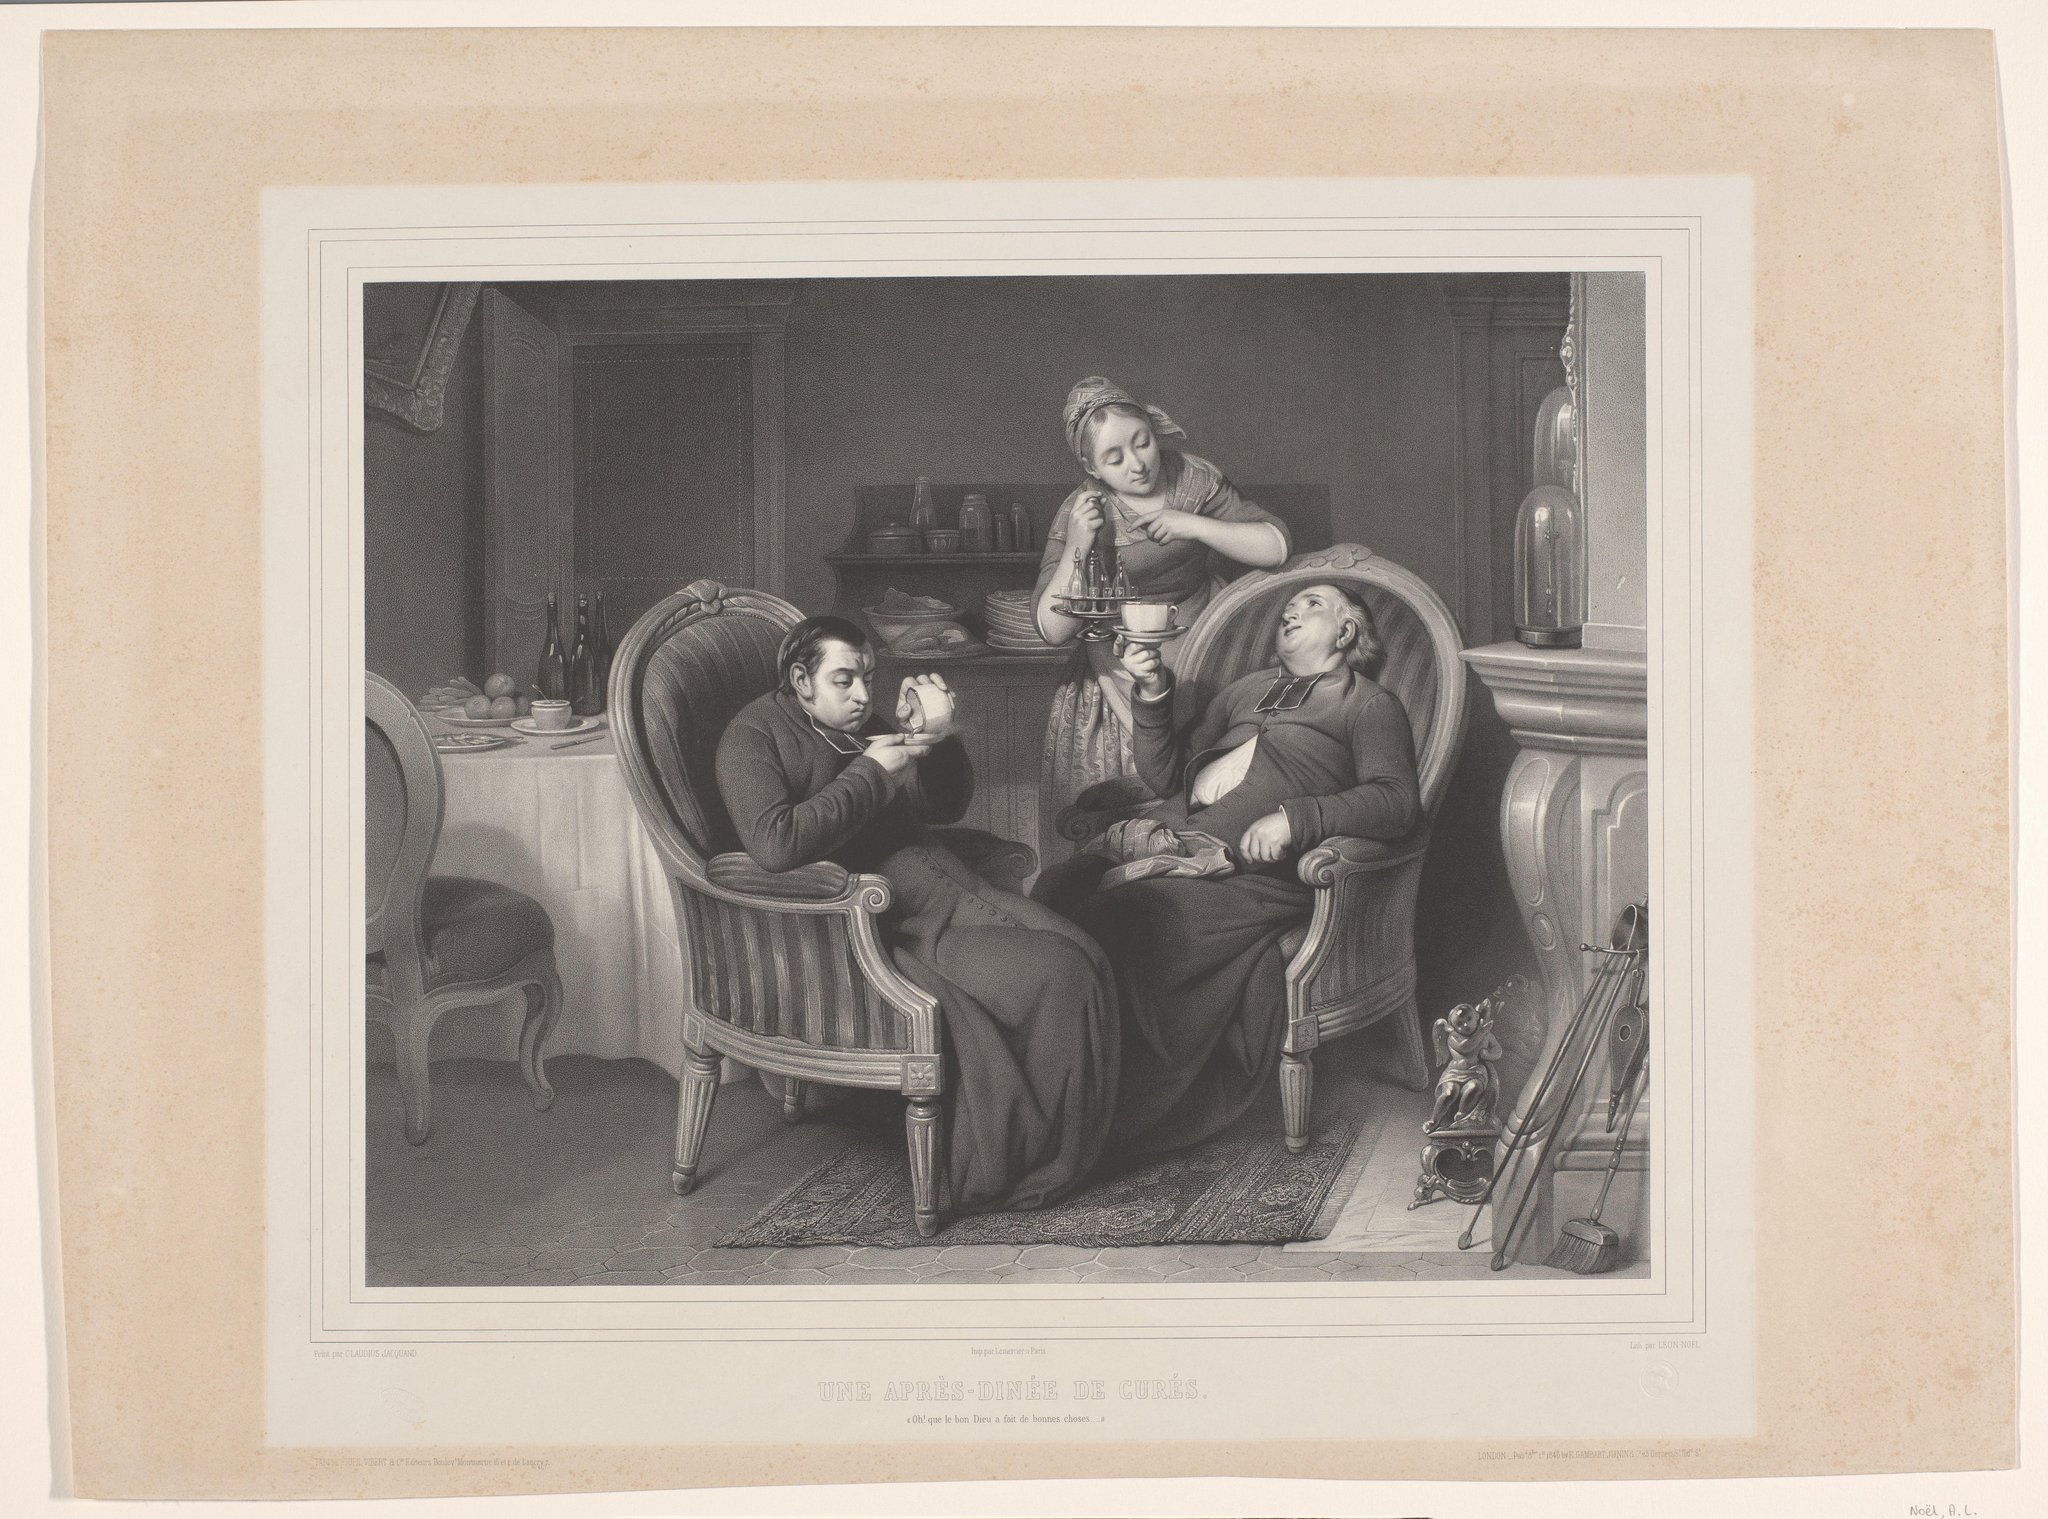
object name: print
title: Twee priesters na de maaltijd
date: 1846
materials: paper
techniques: lithograph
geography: paris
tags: nutrition, nourishment, priest (roman catholic), blowing, to cool food before eating, alcoholic drinks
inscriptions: collector's mark: Lugt 2228, check stamp: Lugt 5004, check stamp: Lugt 4742